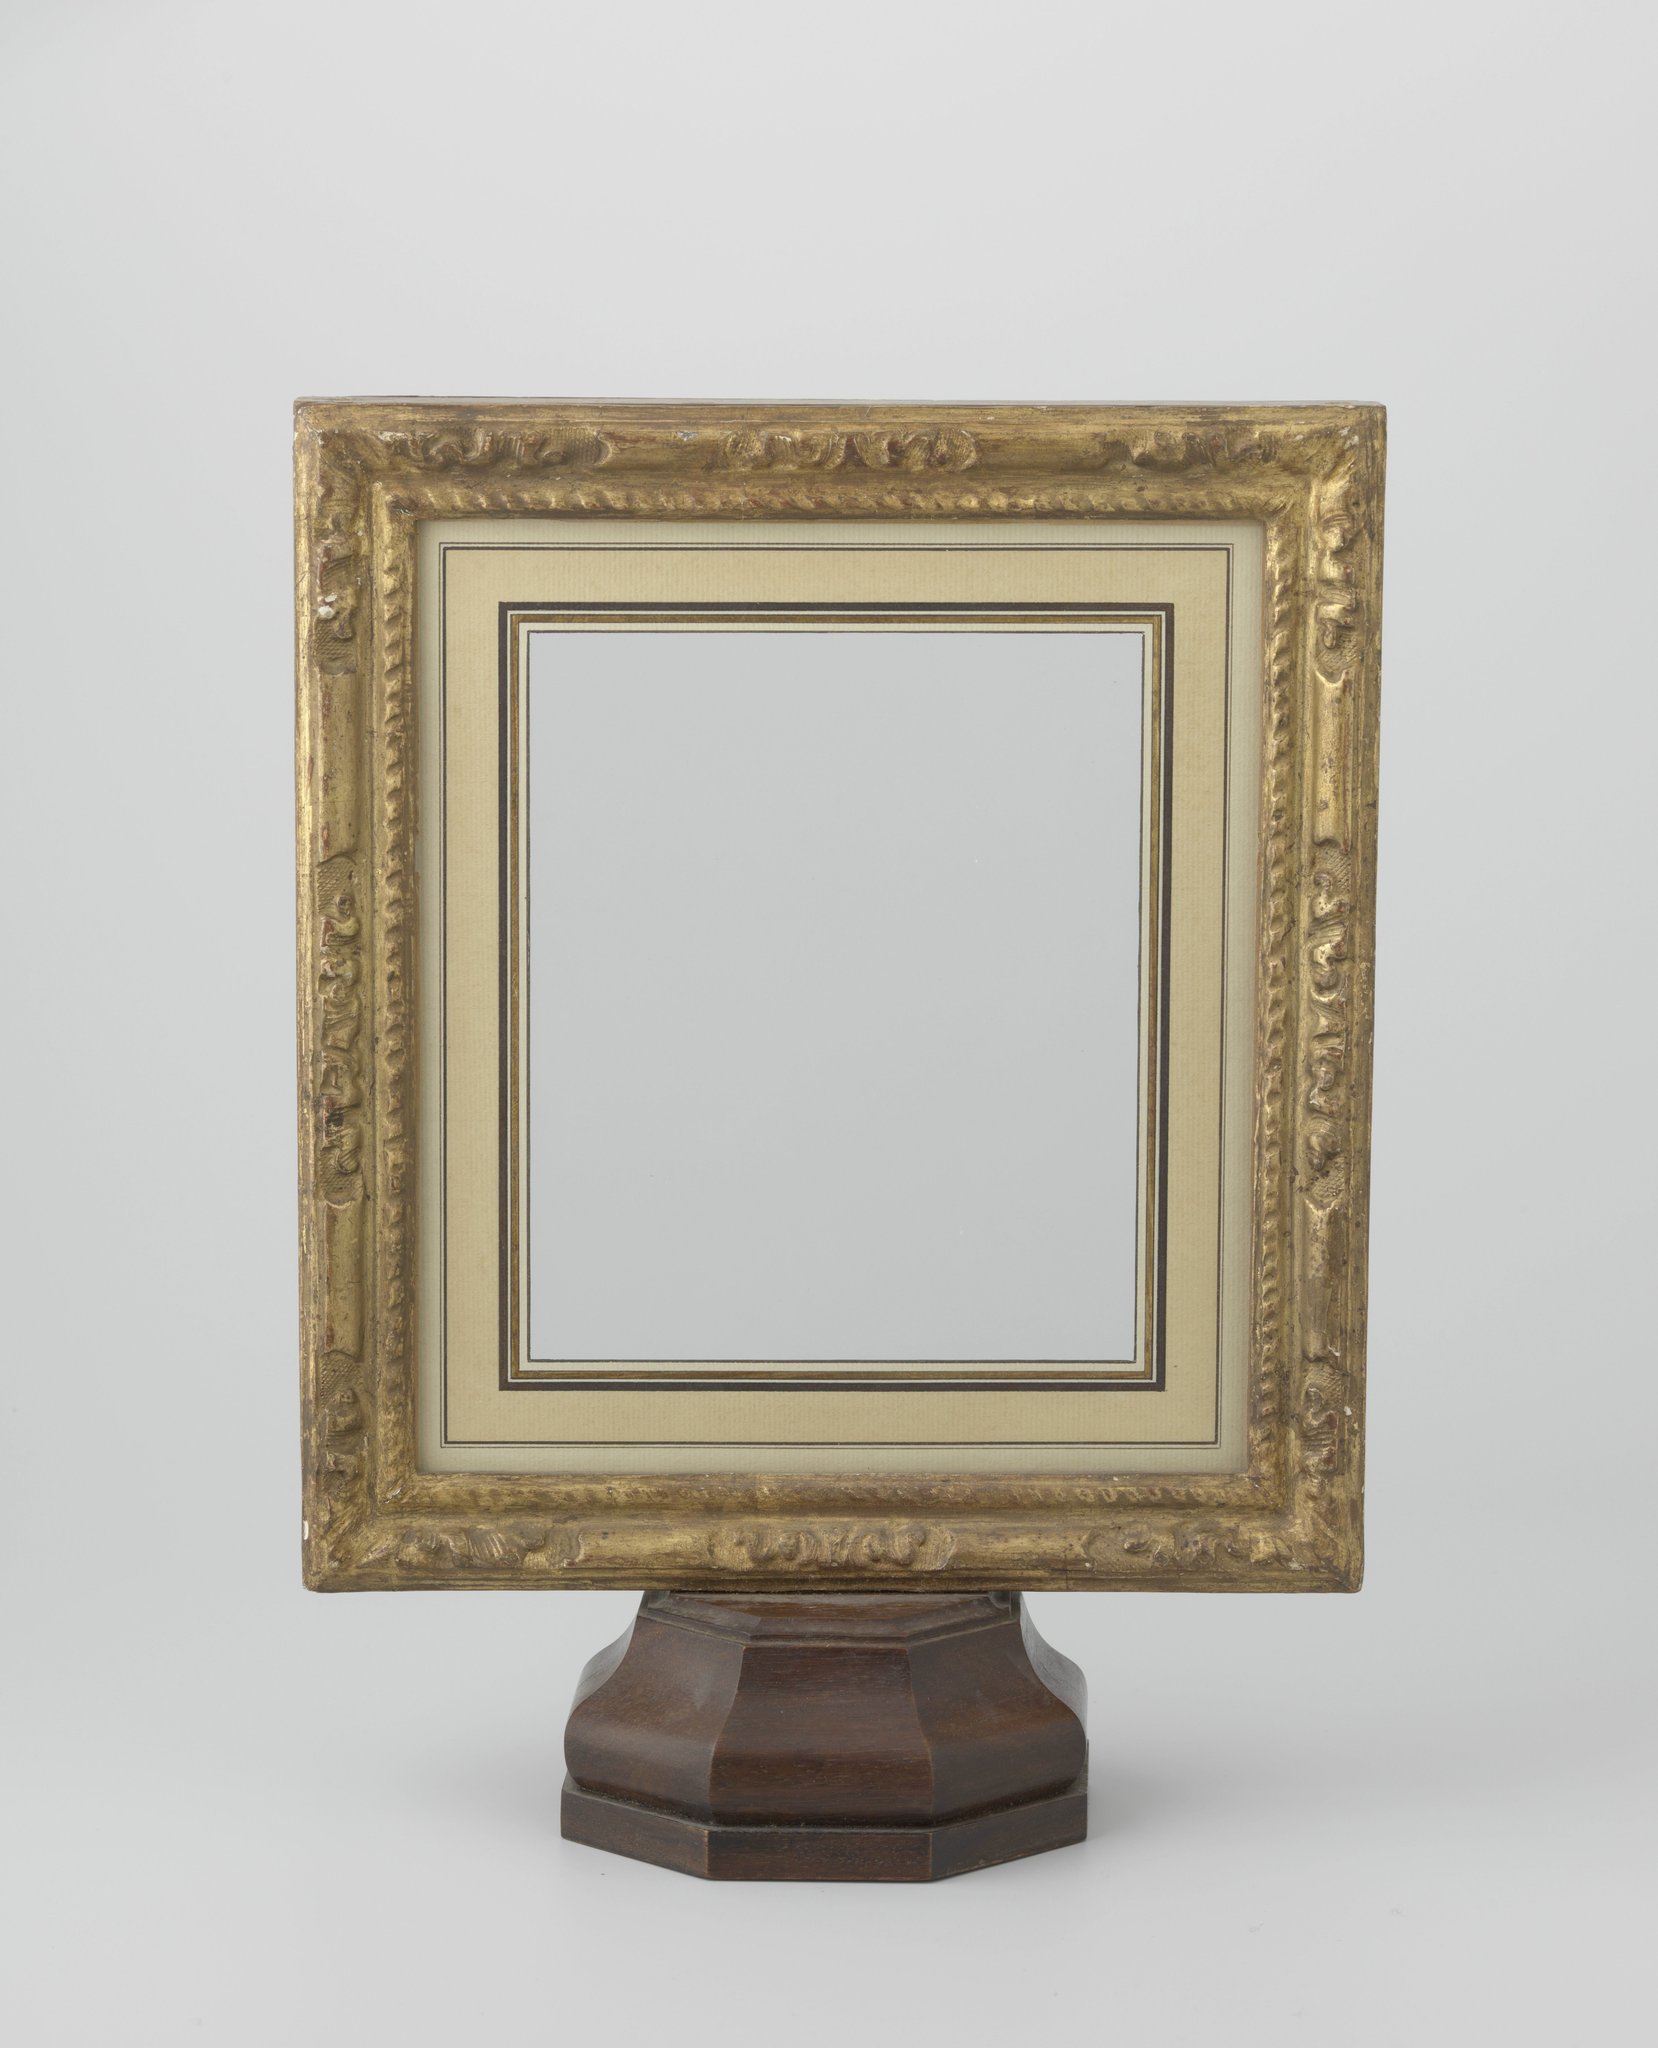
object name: frame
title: 19e-eeuwse Franse tweezijdige vergulde en gesneden lijst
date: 1850-1899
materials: wood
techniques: cutting, gilding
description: De lijst is geïnspireerd op de Le Brunlijsten. De lijst bevat twee glasplaatjes. Het voetstuk is later aan de lijst vastgemaakt met een schroef. De rug, ter hoogte van de bovenregel, kan worden losgeschroefd.